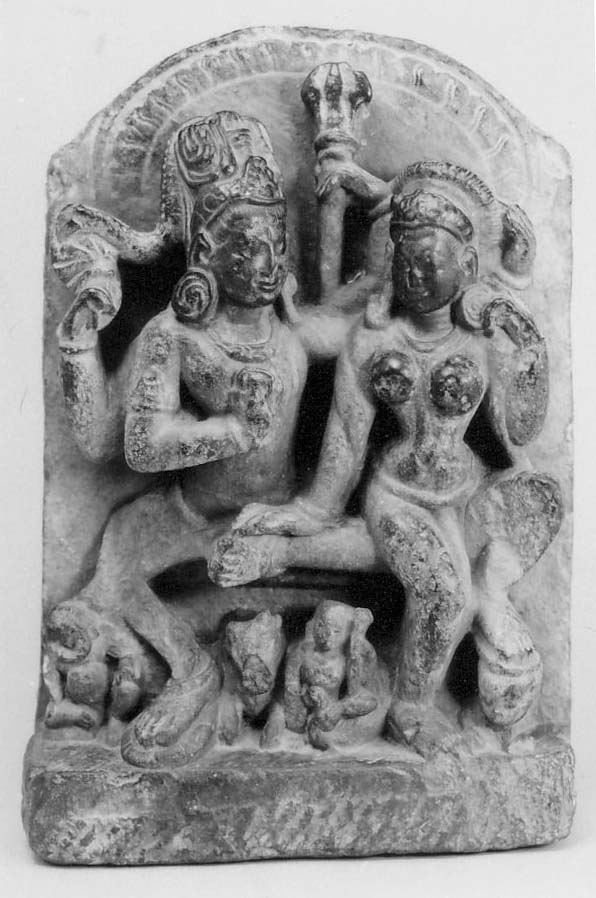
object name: figure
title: Shiva Seated with Parvati (Uma Maheshvara)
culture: indian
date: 867-933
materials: stone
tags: parvati,shiva,hinduism